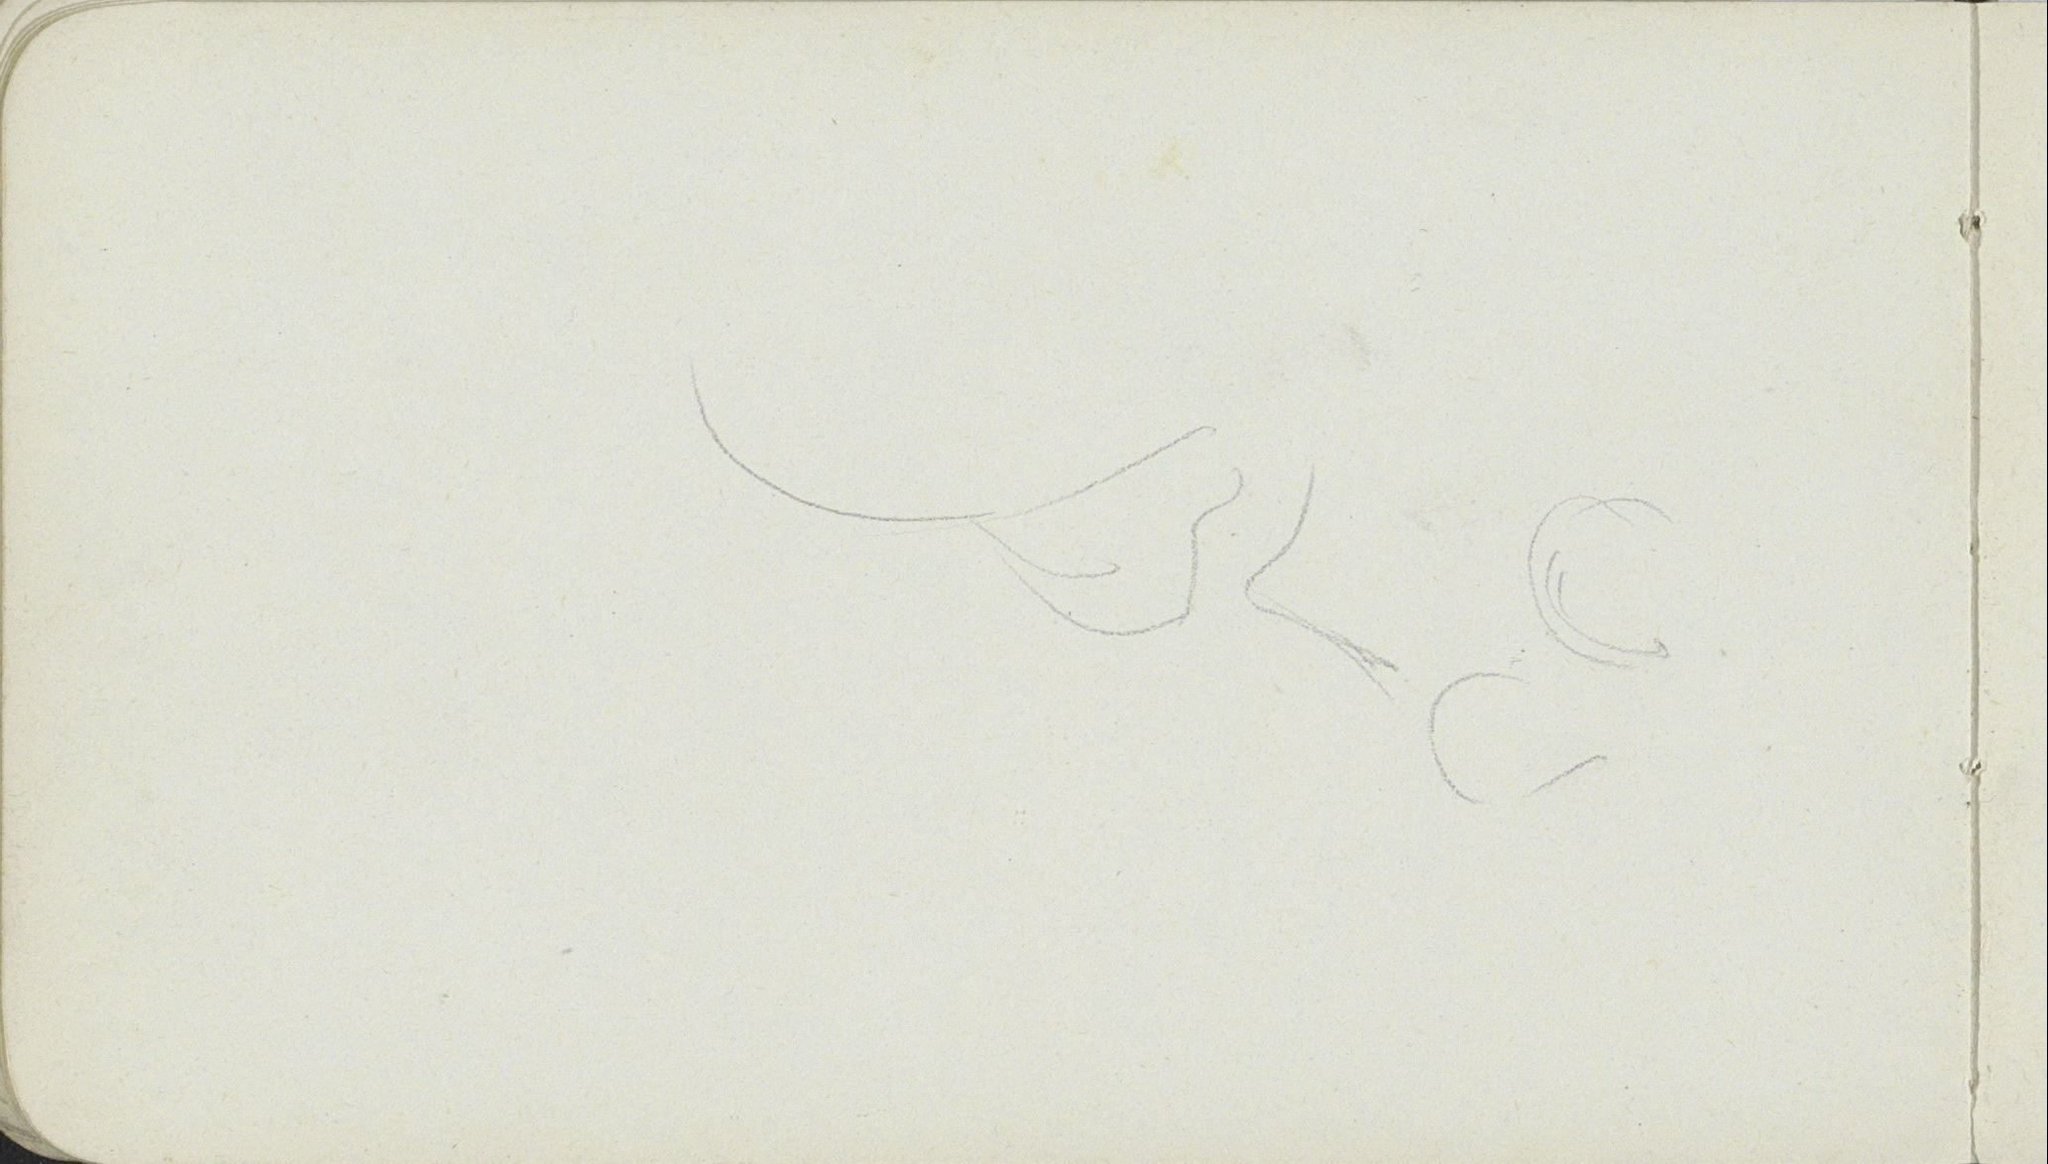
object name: sketchbook leaf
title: Studie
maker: carel adolph lion cachet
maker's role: draughtsman, print maker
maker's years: 1864-1945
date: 1905-1906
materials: paper, pencil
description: Blad 23 verso uit een schetsboek met 34 bladen.